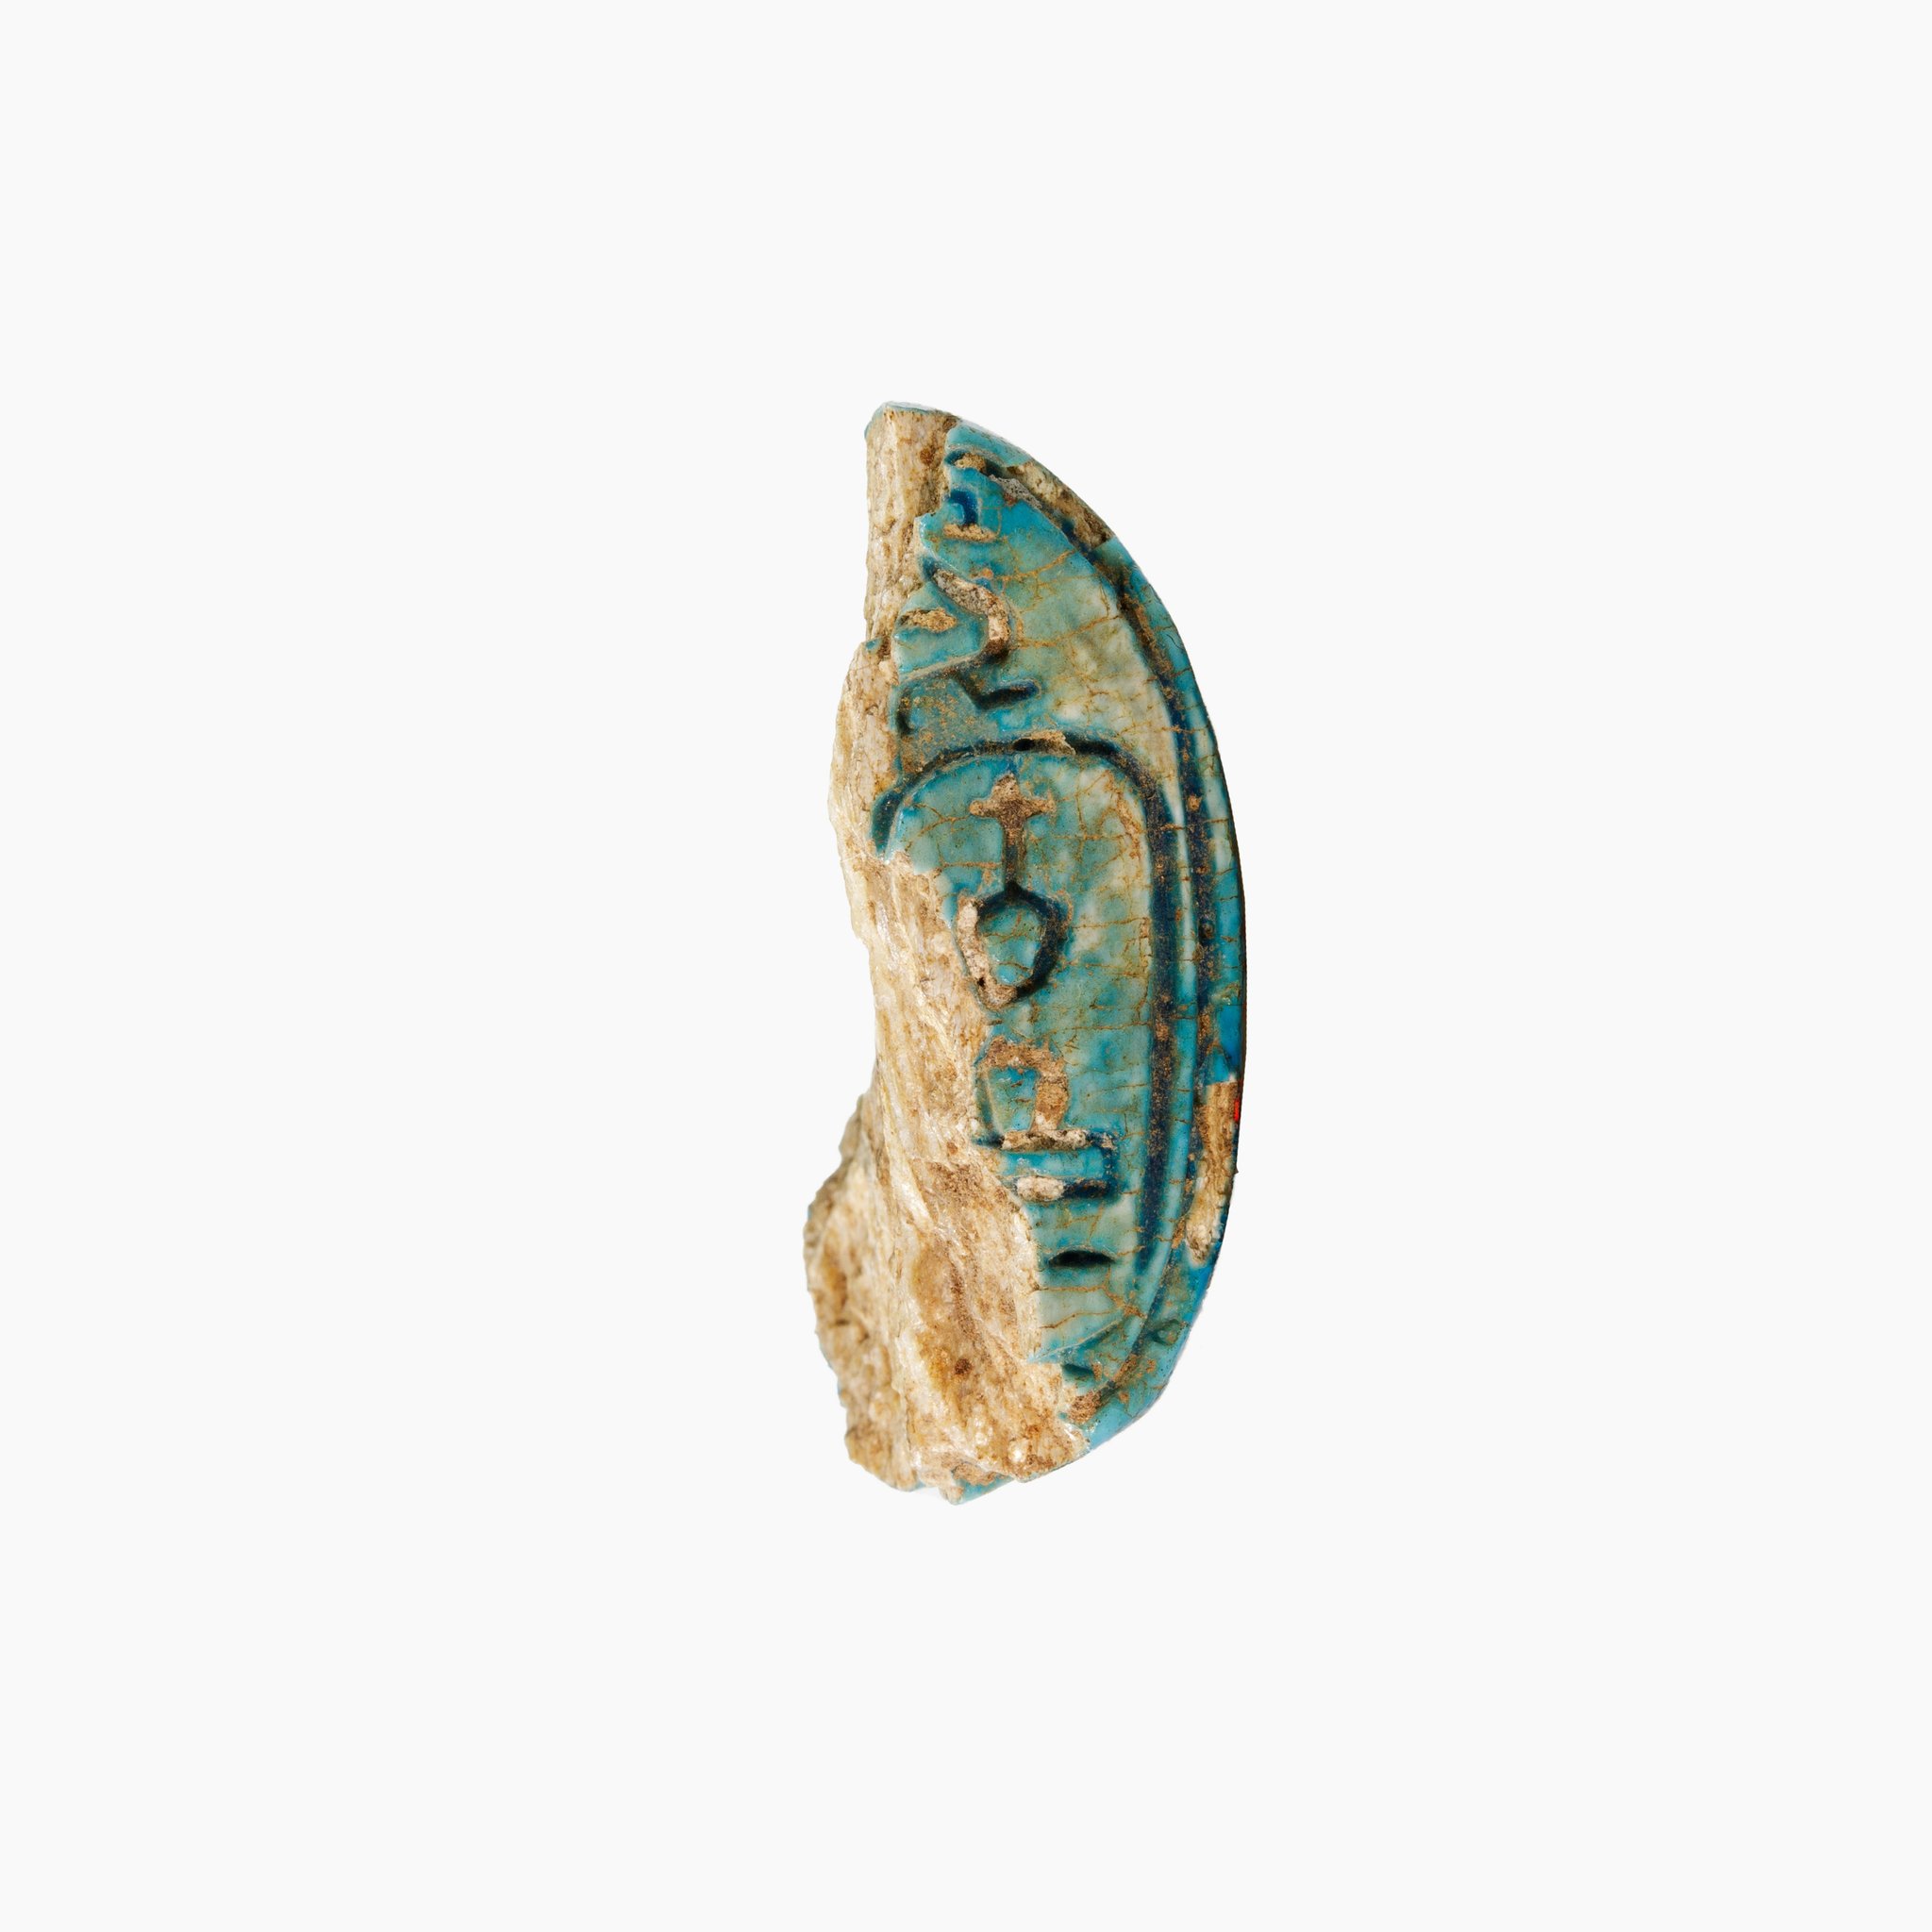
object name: scarab, fragment, neferhotep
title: Part of a Scarab Inscribed for Neferhotep I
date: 1741-1730 BCE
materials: stone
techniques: glazing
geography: egypt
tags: scarabs